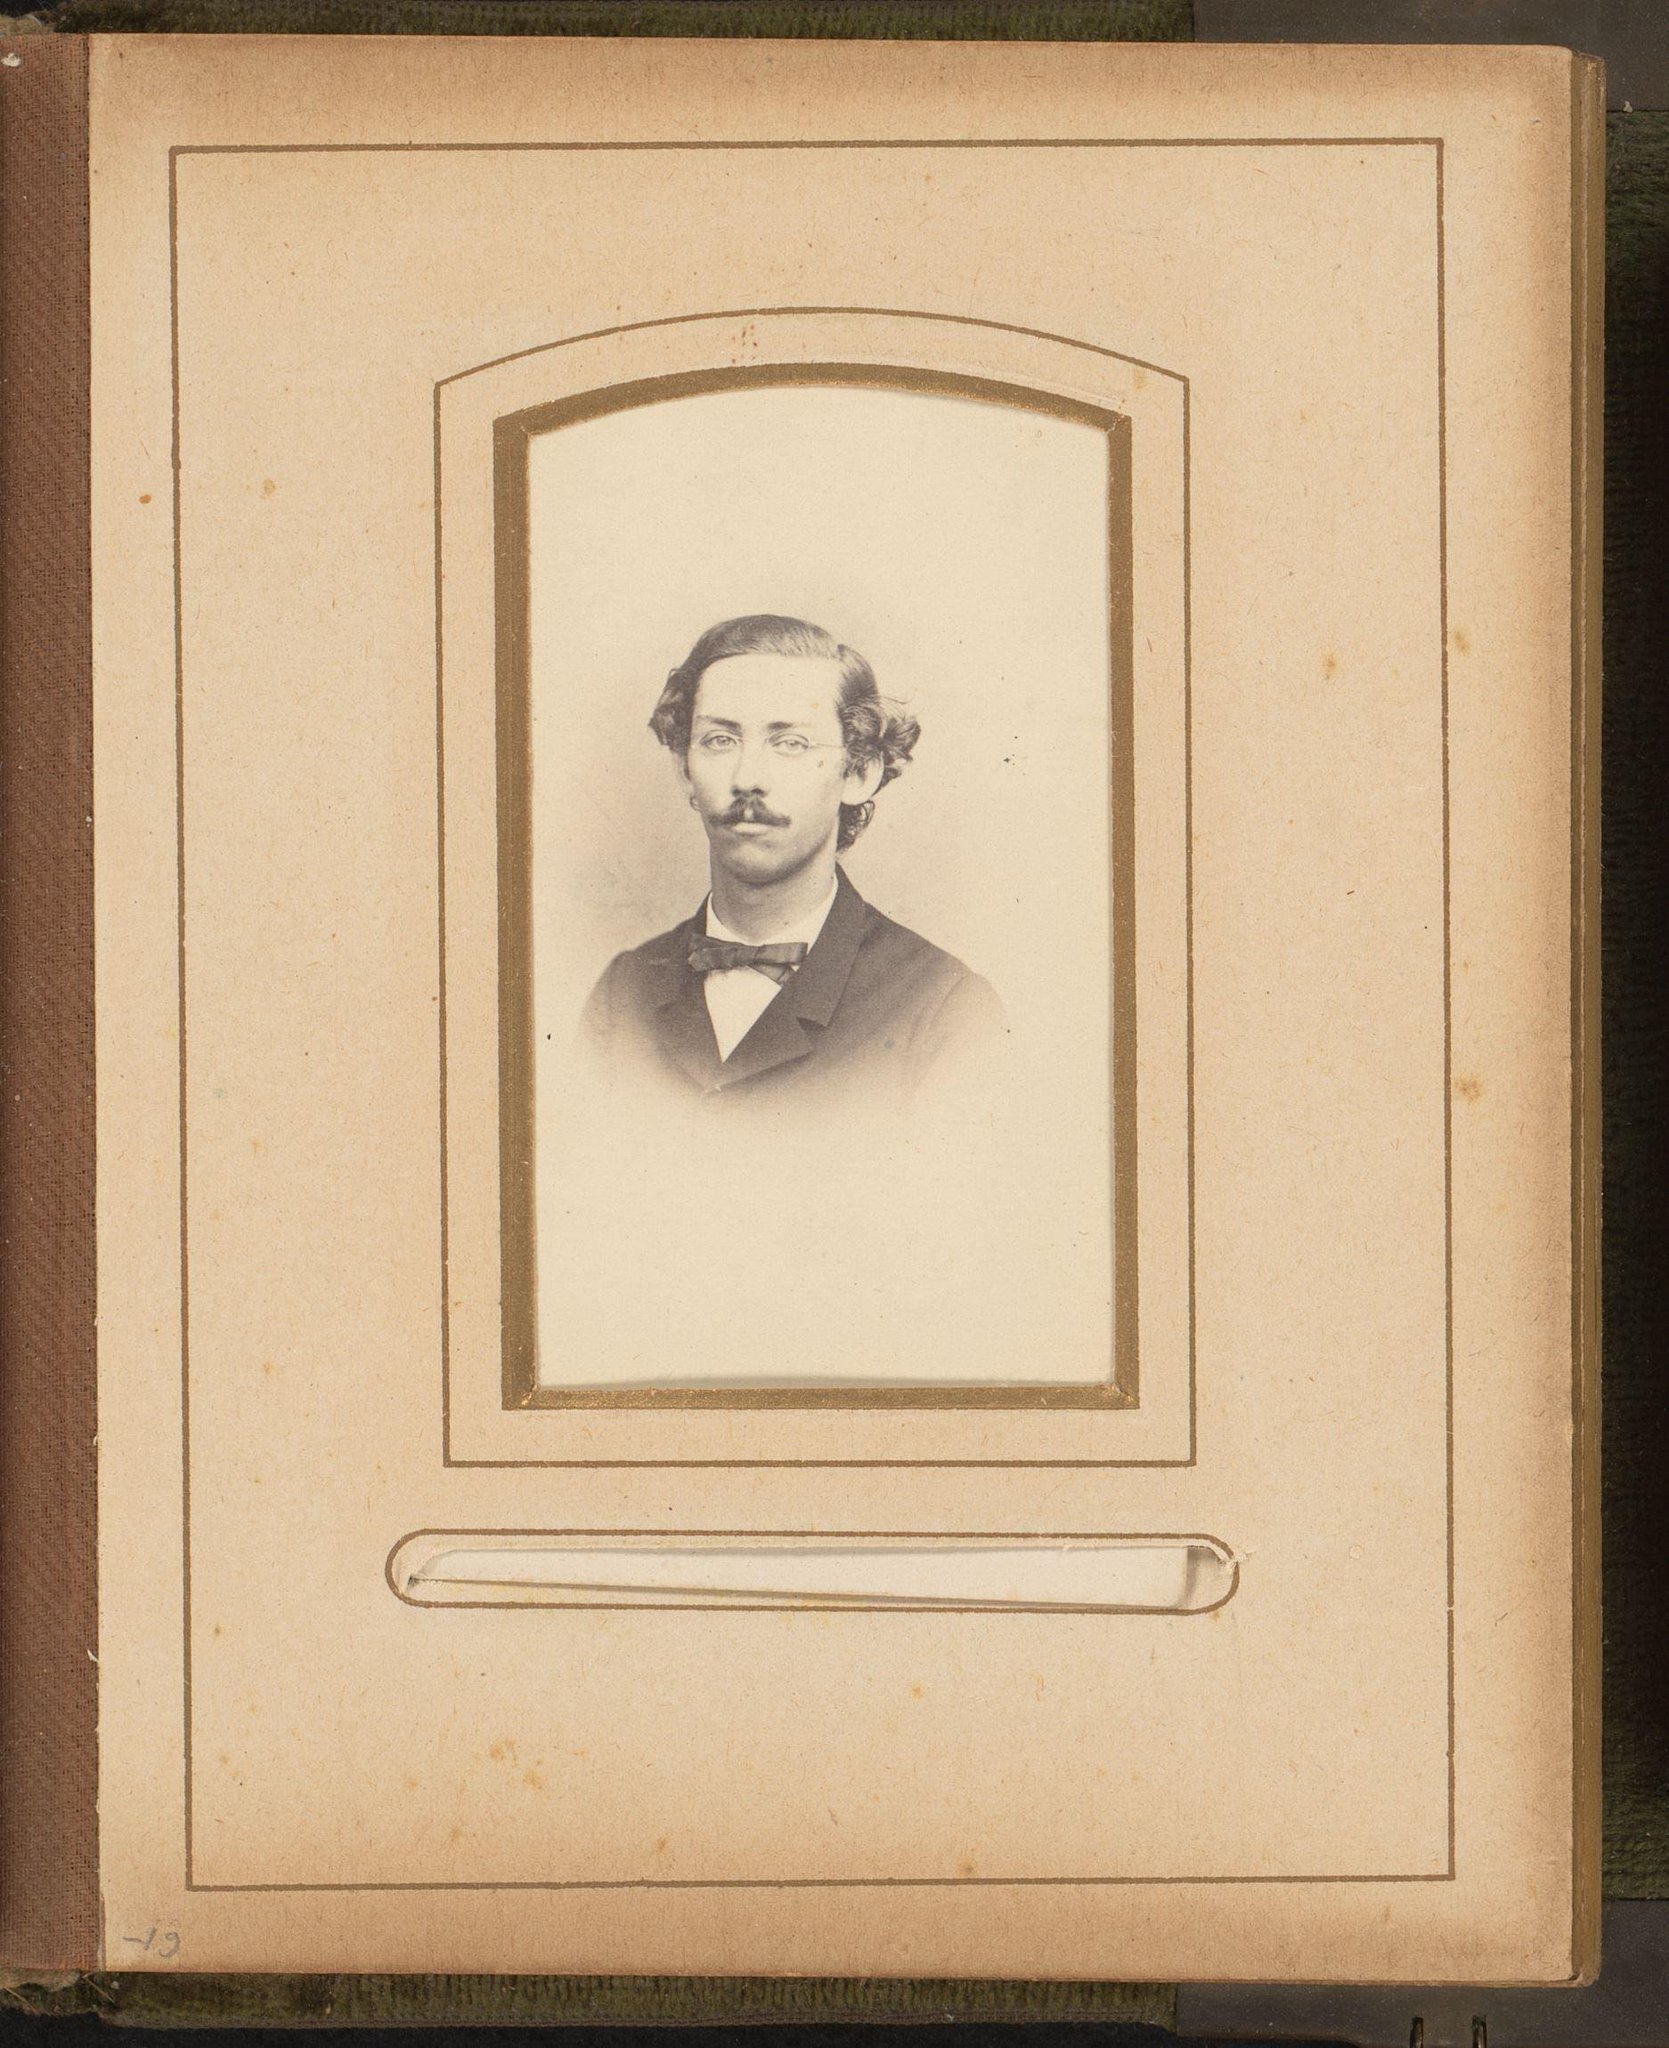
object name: carte de visite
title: Portret van een man, mogelijk lid van de familie Beucker Andreae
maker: Anonymous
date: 1854-1885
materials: cardboard, paper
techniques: albumen print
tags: adult man, anonymous historical person portrayed